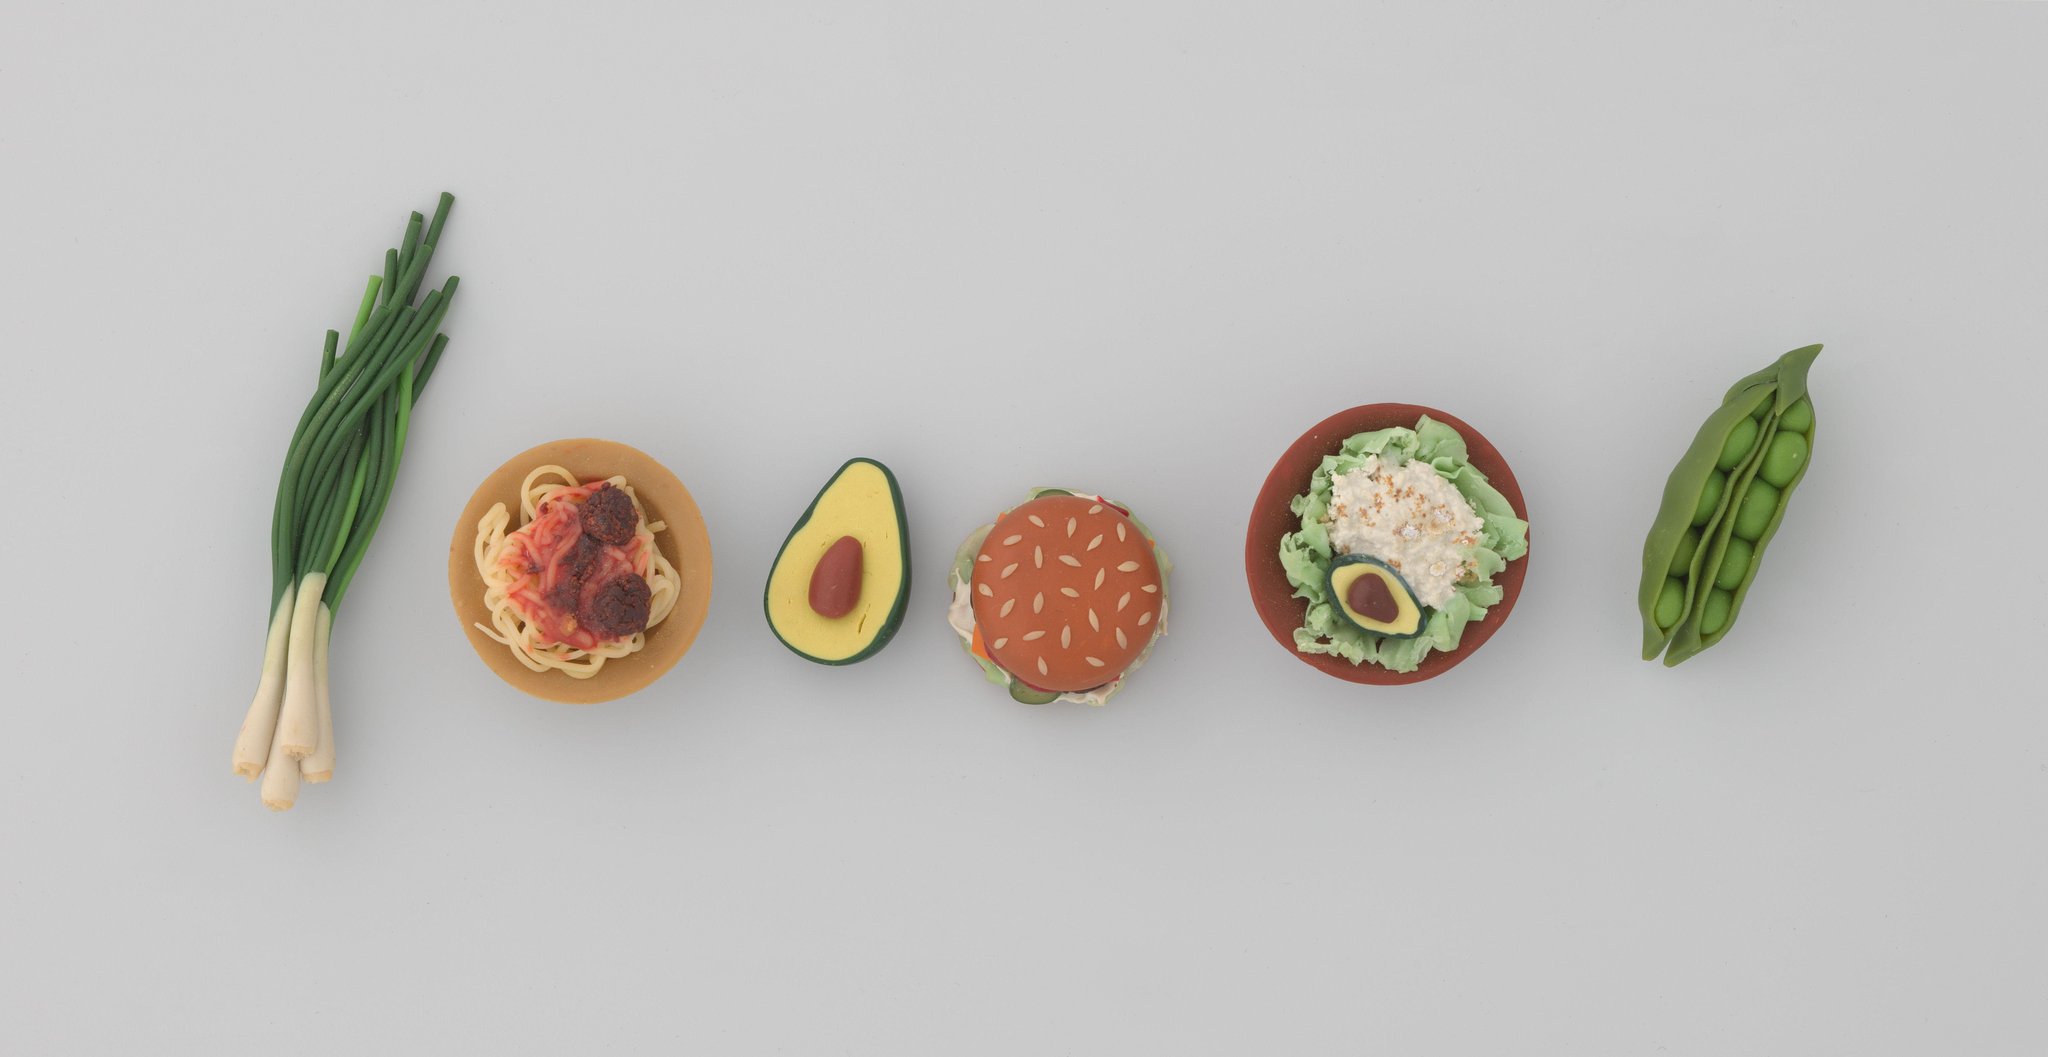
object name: brooch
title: Prei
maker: Anonymous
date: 1970-1980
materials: metal, plastic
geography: united states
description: Broche van kunststof met kogelsluiting van metaal.